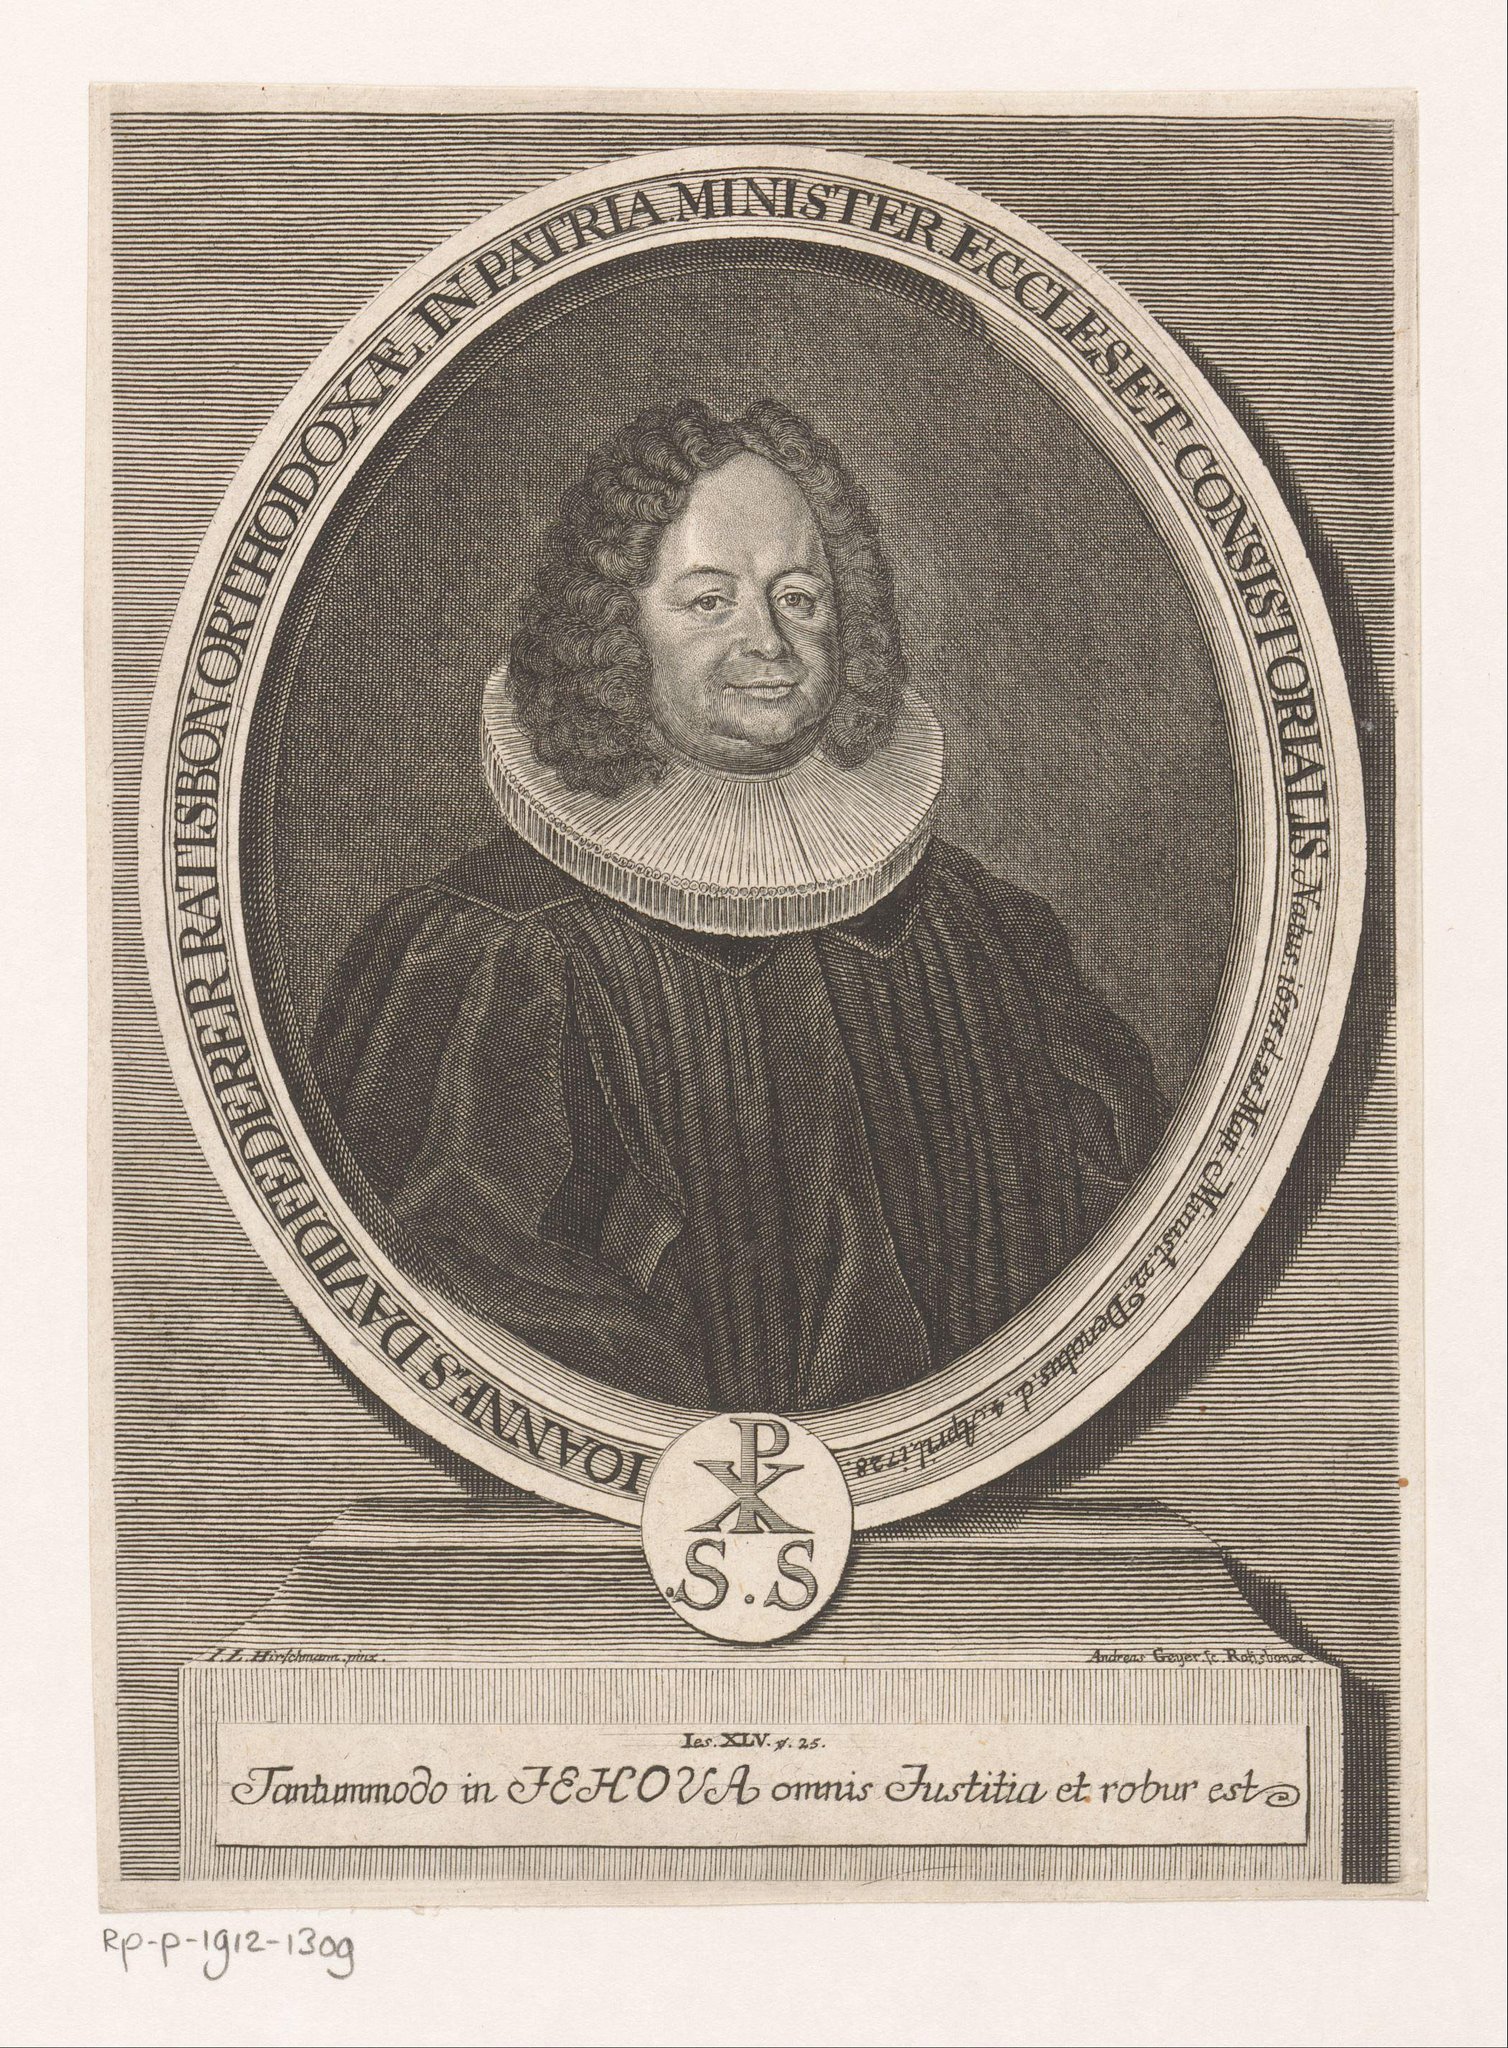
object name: print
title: Portret van Johann David Federer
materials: paper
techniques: engraving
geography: regensburg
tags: ornament ~ medallion, historical persons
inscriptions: collector's mark: Lugt 2228